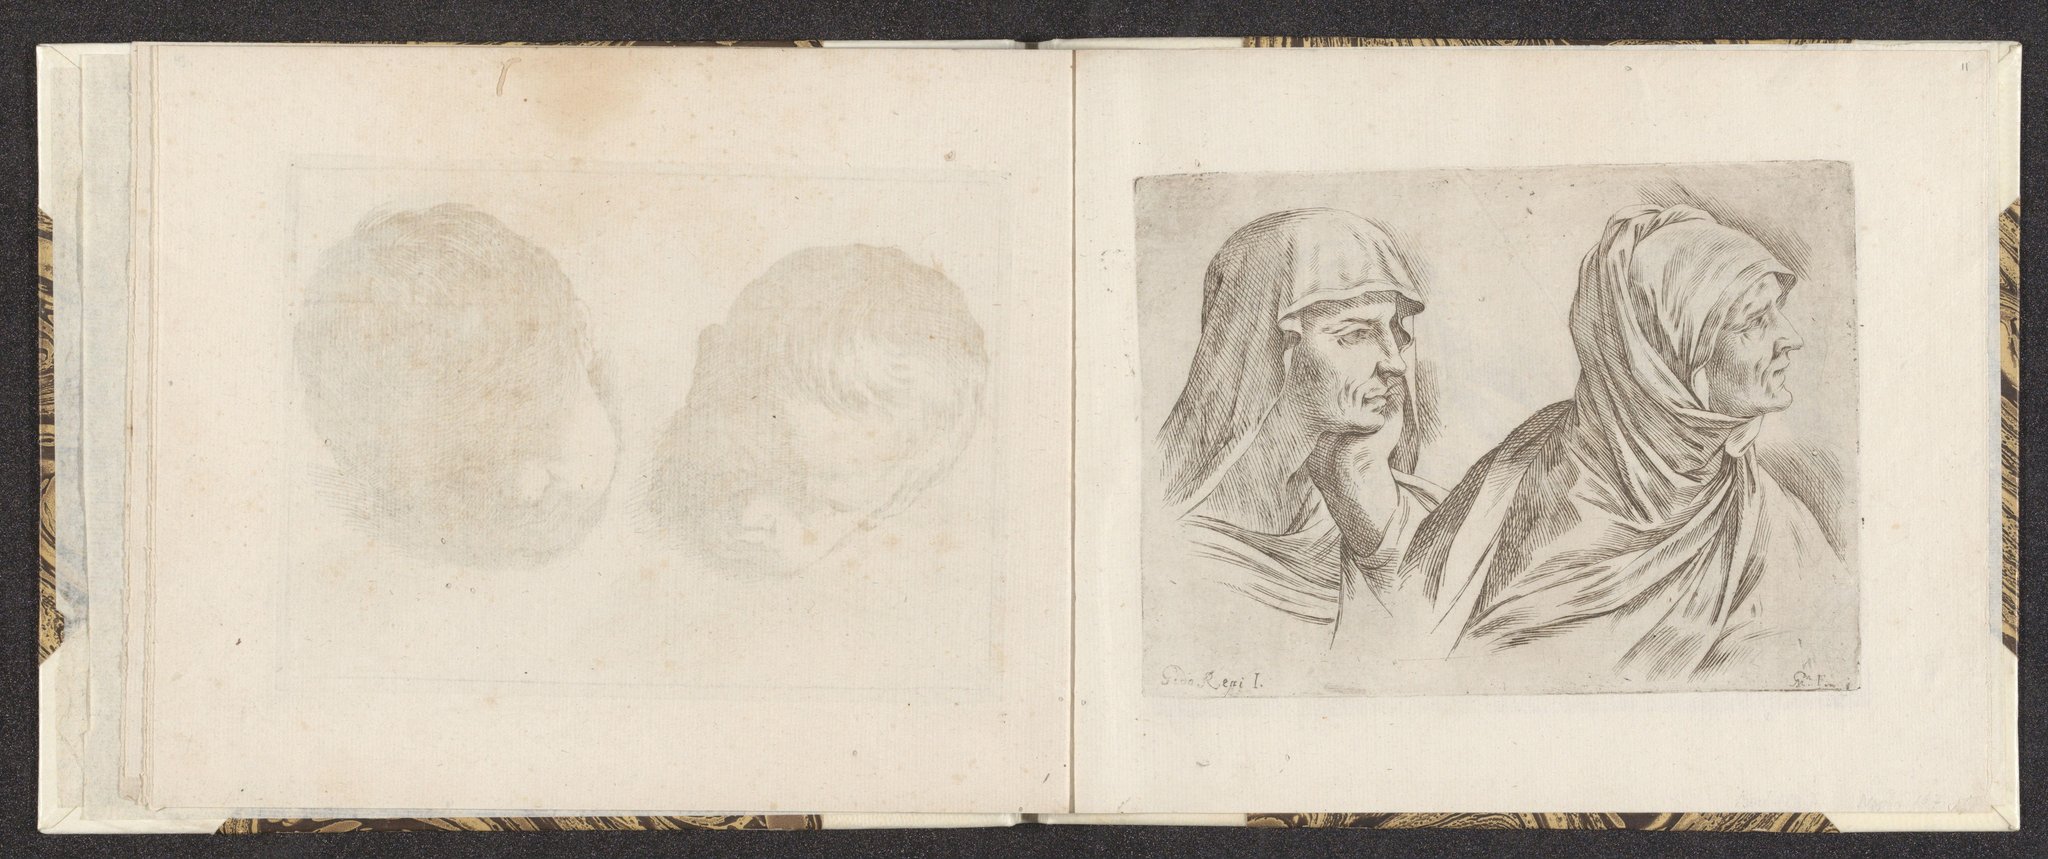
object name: print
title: Tekenvoorbeelden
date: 1663-1666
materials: paper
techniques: etching, intaglio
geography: italy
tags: face, model-books ~ implements of painter, old woman (+ sideview, profile), veil